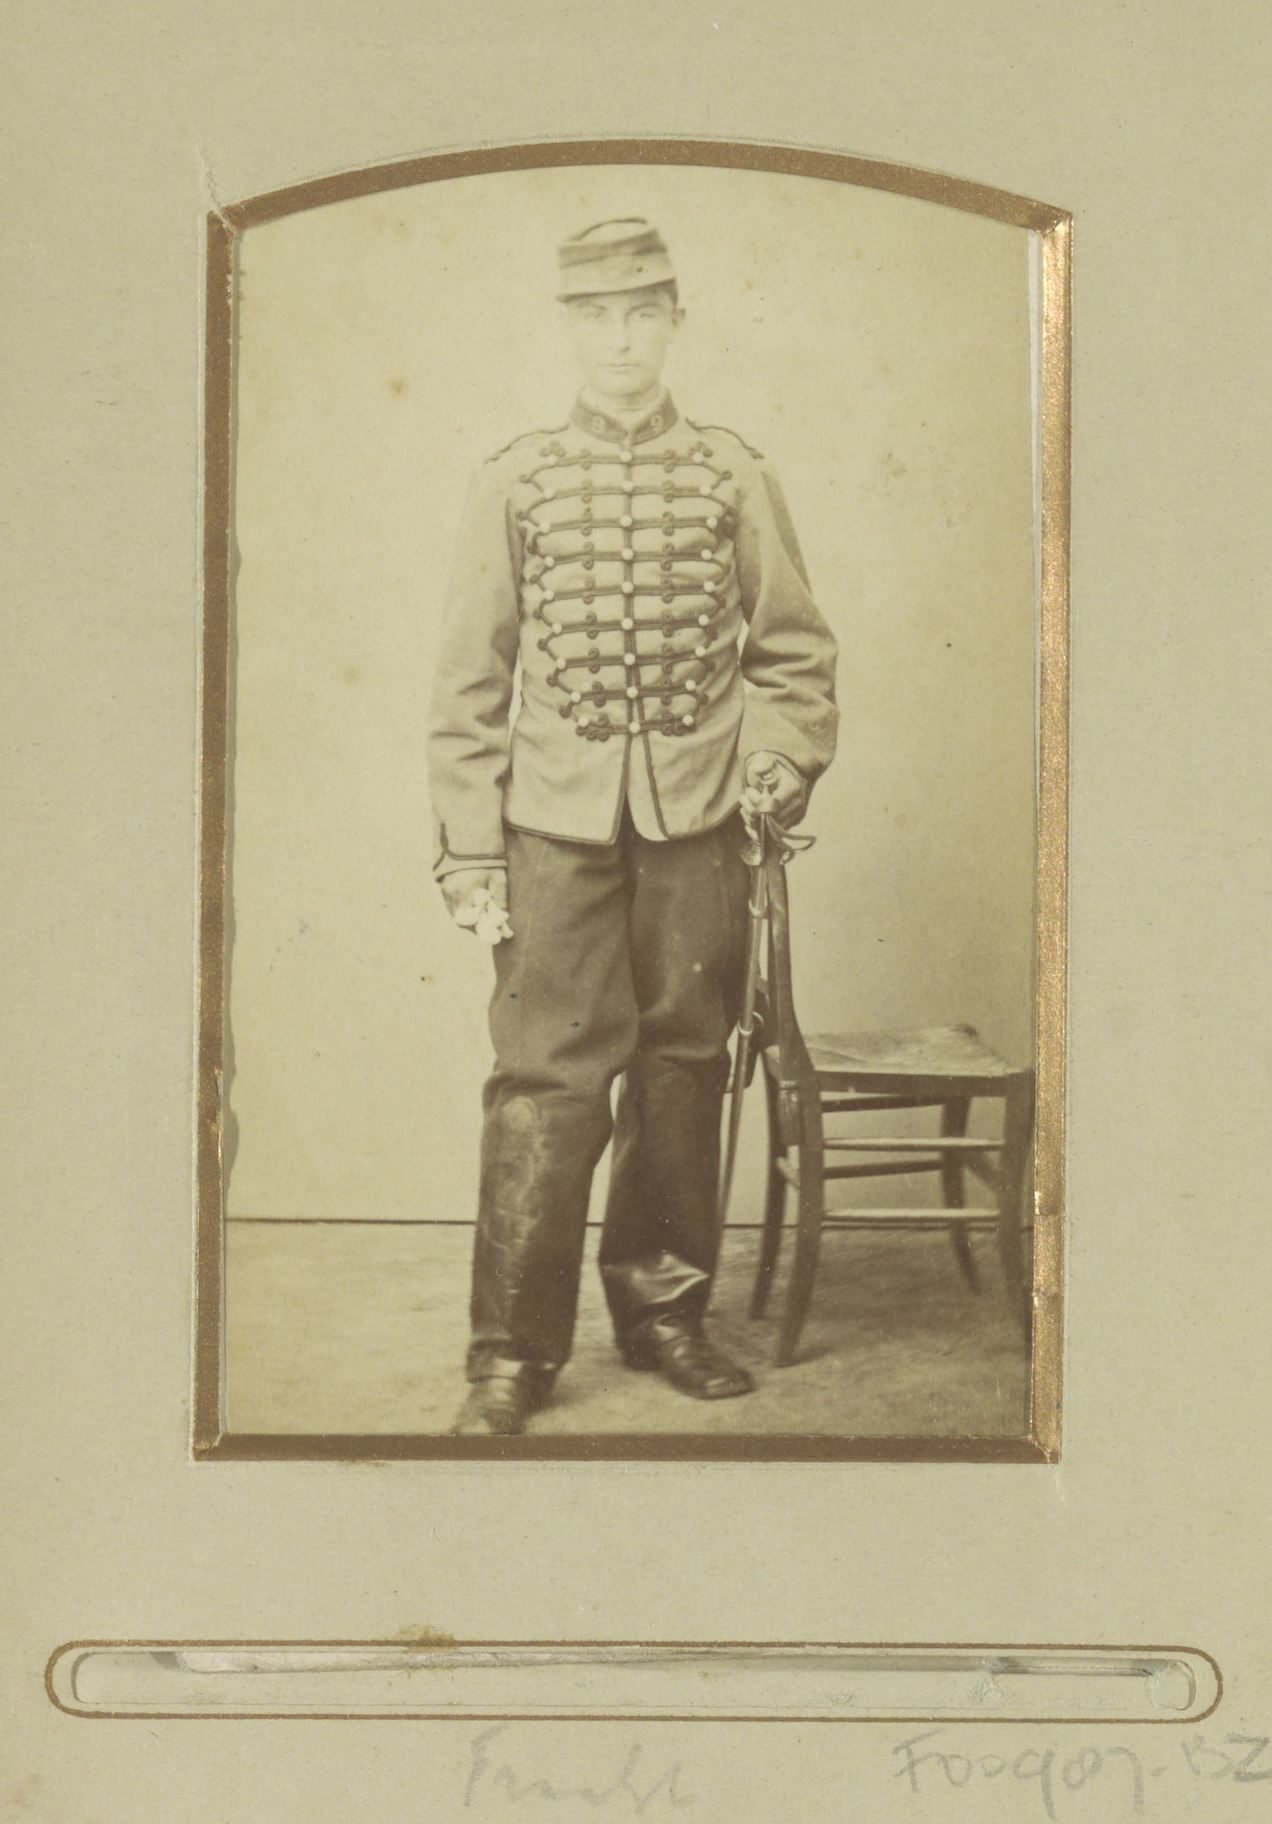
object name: photograph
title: Portret van een (vermoedelijk) Franse militair, staand met sabel in de hand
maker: Anonymous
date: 1870-1910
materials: cardboard, paper, photographic support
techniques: albumen print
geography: france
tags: studio requisites ~ photographer, hacking and thrusting weapons (with name), warfare; military affairs, (military) uniforms, division of armed forces, france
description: Onderdeel van Album met cartes-de-visite en kabinetfoto's van militairen in uniform.